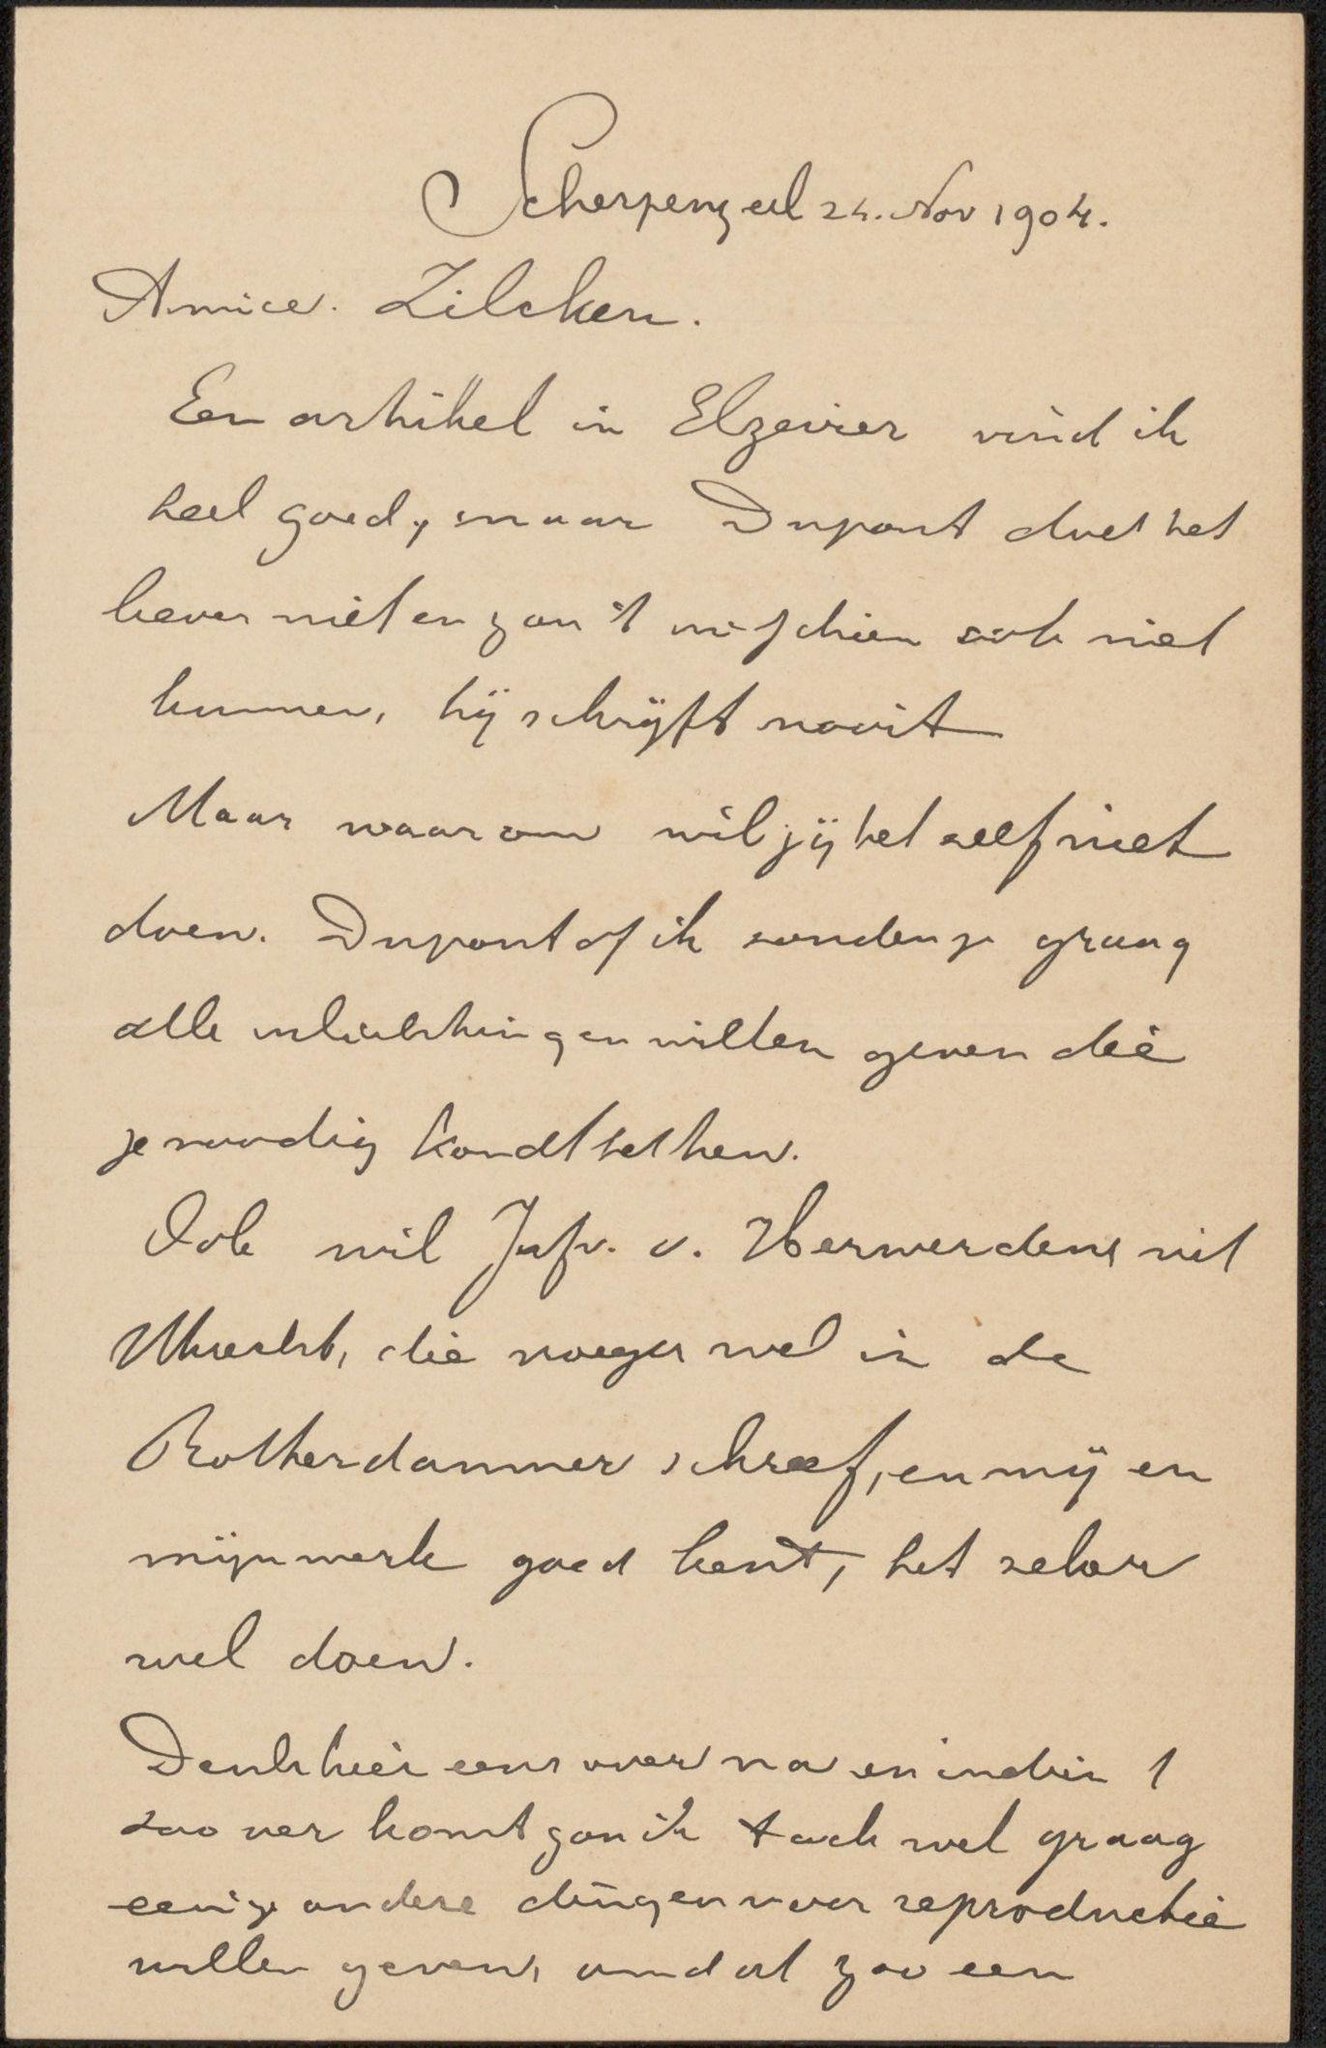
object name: letter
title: Brief aan Philip Zilcken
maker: maurits van der valk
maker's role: draughtsman, print maker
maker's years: 1857-1935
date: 1904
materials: ink, paper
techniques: pen, writing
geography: scherpenzeel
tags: pieter dupont, utrecht, the hague, philip zilcken, exhibition ~ art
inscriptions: collector's mark: ‘RPK’